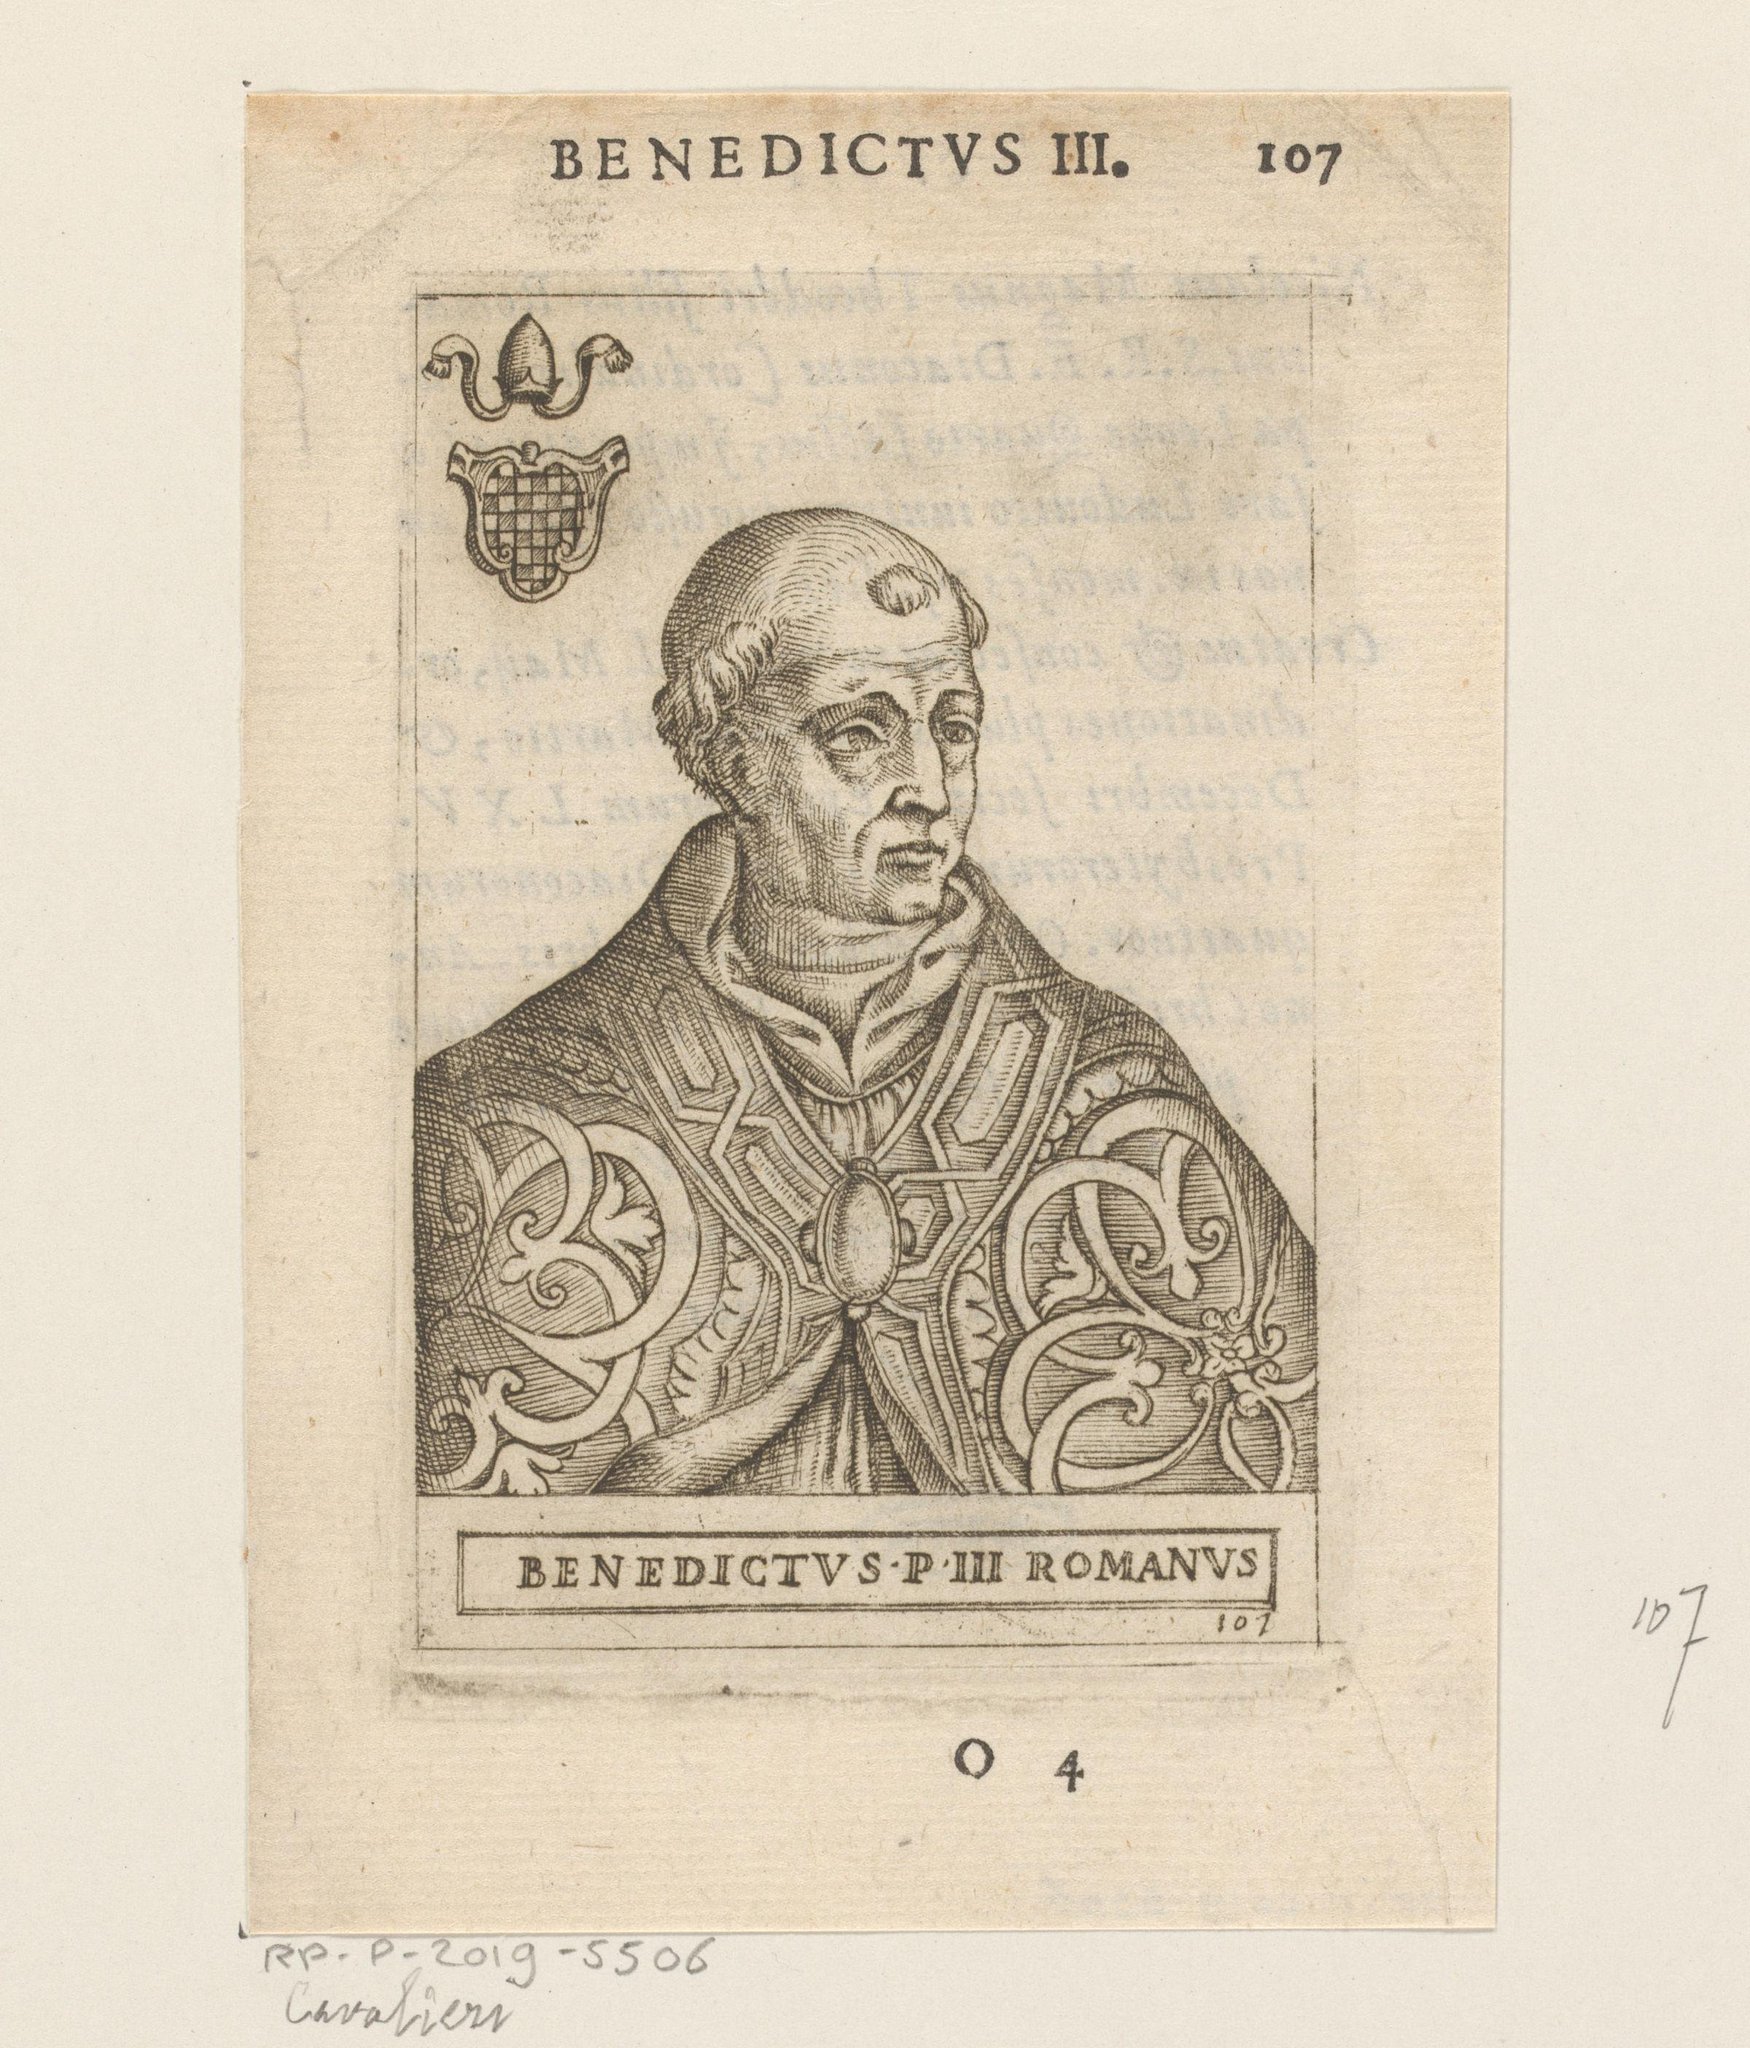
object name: book illustration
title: Portret van paus Benedictus III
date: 1595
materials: paper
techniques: engraving, letterpress printing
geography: rome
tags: rome, historical persons, pope, armorial bearing, heraldry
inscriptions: collector's mark: Lugt 2228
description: Prent uit: Cavalieri, Giovanni Battista de'. Effigies pontificum romanorum cum eorum vitis (...). Rome: Bartolomeo Bonfadino, 1595. Prent voor het eerst verschenen in: Cavalieri, Giovanni Battista de'. Pontificum romanorum effigies (...). Rome: Domenico Basa en Francesco Zanetti, 1580. Prent ook gebruikt in latere publicaties.